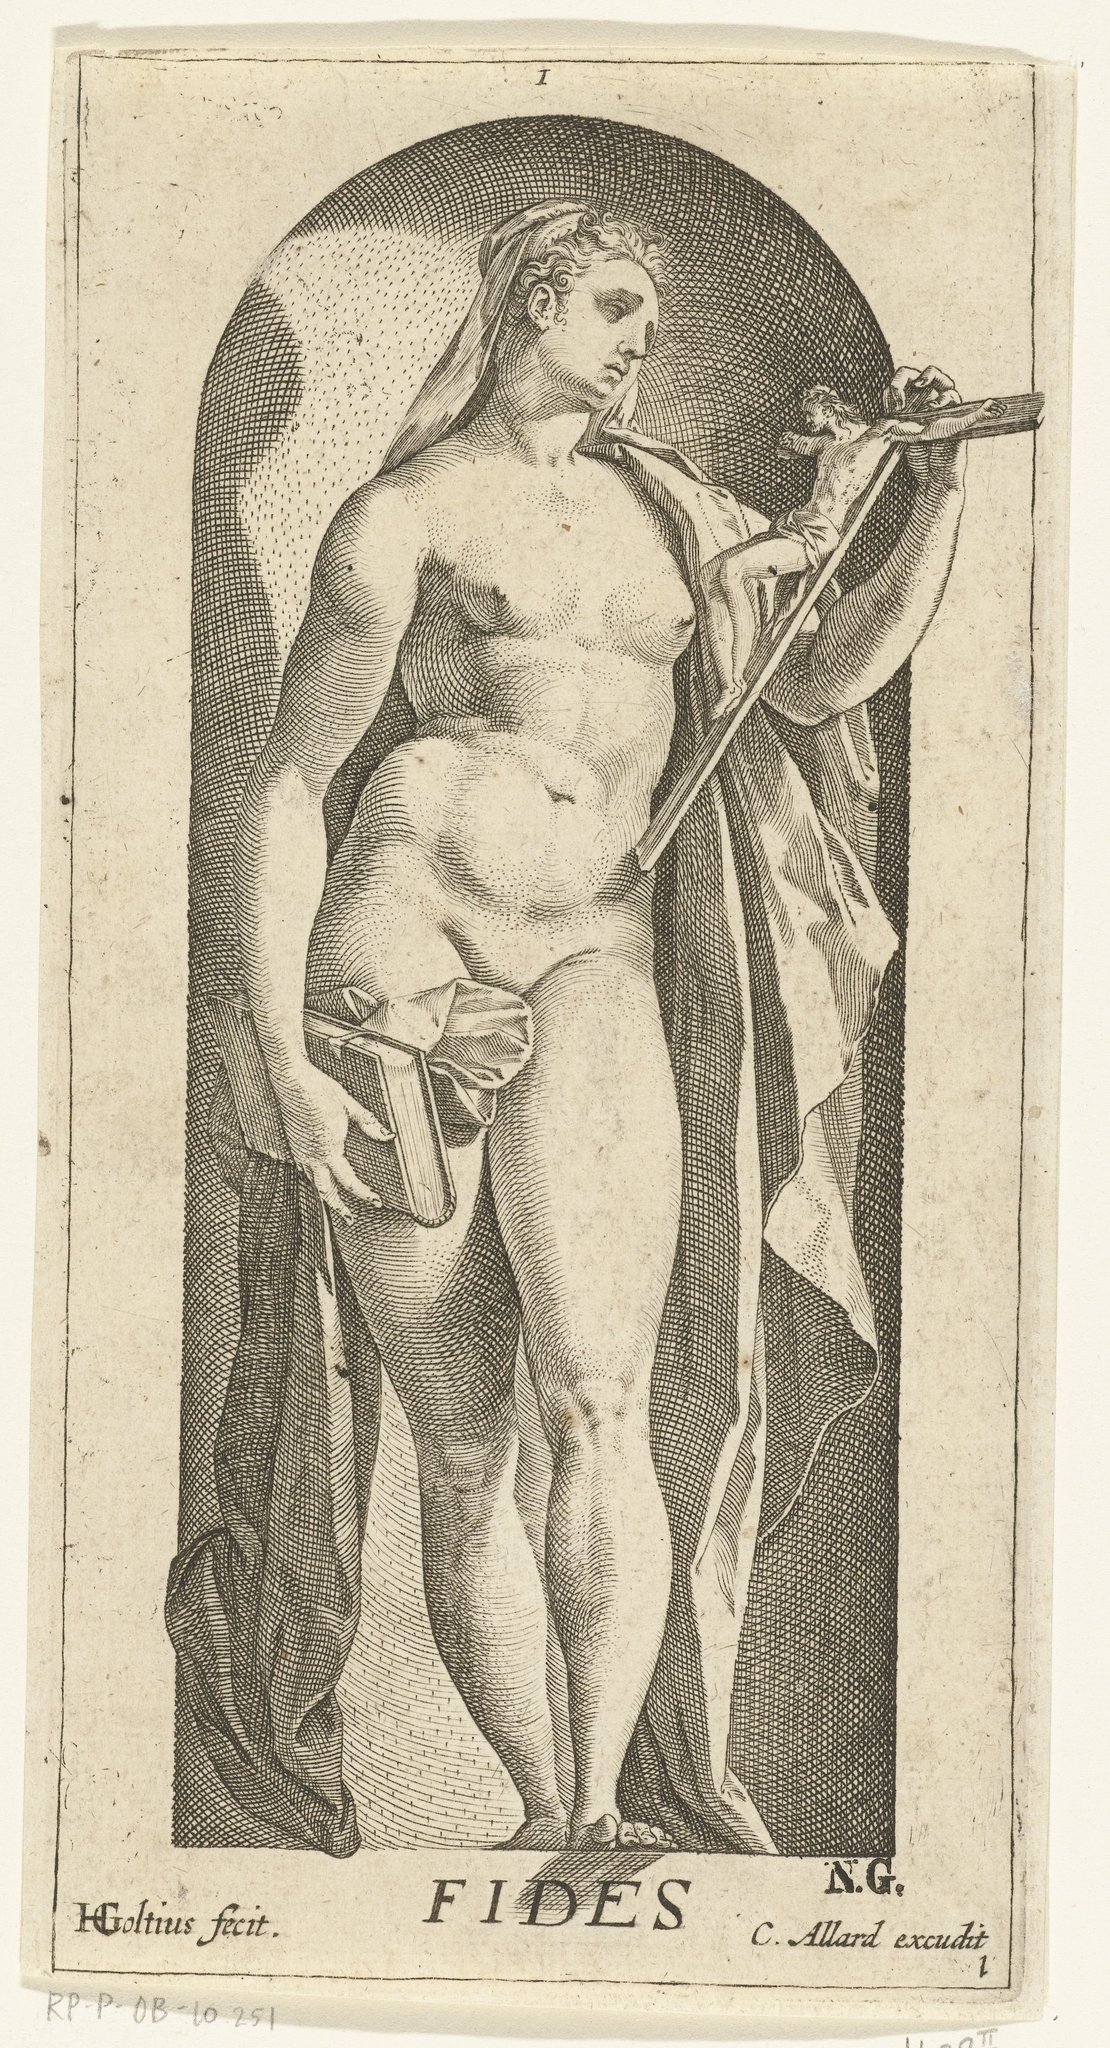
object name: print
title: Geloof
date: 1578-1582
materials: paper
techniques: engraving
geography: amsterdam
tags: faith, 'fides'; 'fede', 'fede catholica', 'fede christiana', 'fede christiana catholica' (ripa) ~ one of the three theological virtues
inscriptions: collector's mark: Lugt 1967, collector's mark: Lugt 2228a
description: Het Geloof, voorgesteld als een vrijwel naakte vrouw met een crucifix in de ene hand en een boek in de andere. Deze prent is onderdeel van een prentserie van de zeven deugden, elk in de gedaante van een vrouwenfiguur met attributen, staand in een nis.